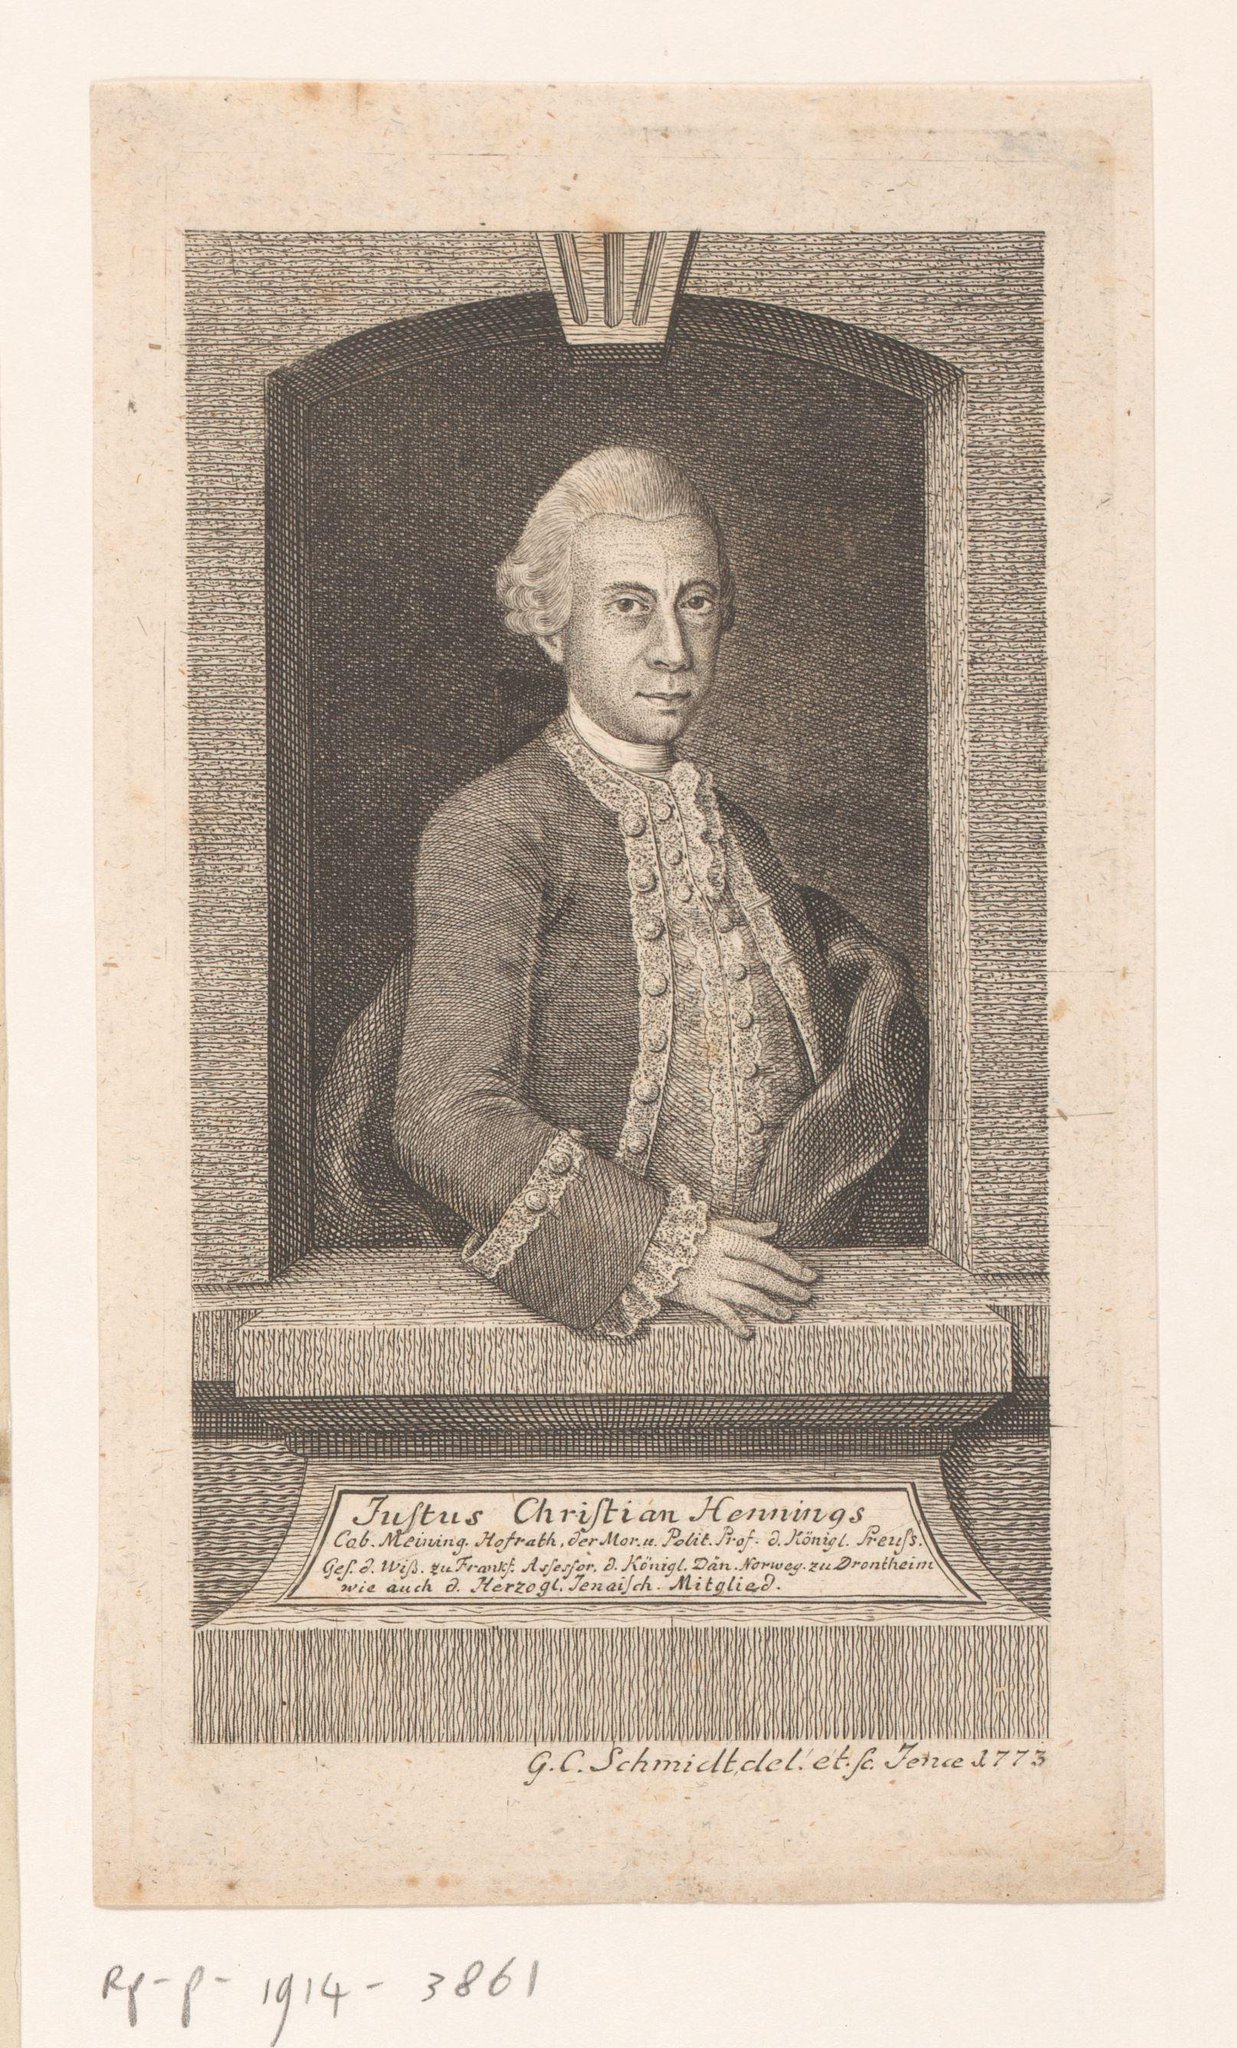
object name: print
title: Portret van Justus Christian Hennings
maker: georg christoph schmidt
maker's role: print maker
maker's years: 1740-1811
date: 1773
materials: paper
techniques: etching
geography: jena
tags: historical persons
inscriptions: collector's mark: Lugt 2228